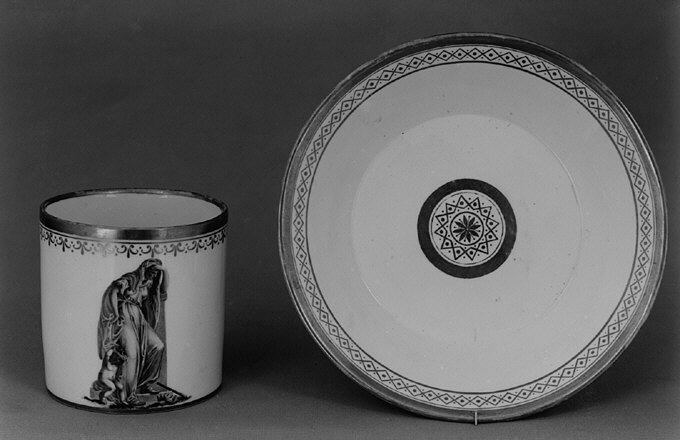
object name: saucer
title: Saucer (part of a coffee service)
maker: nymphenburg porcelain manufactory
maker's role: manufactory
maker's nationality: german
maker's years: 1747-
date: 1801-1833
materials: hard paste porcelain